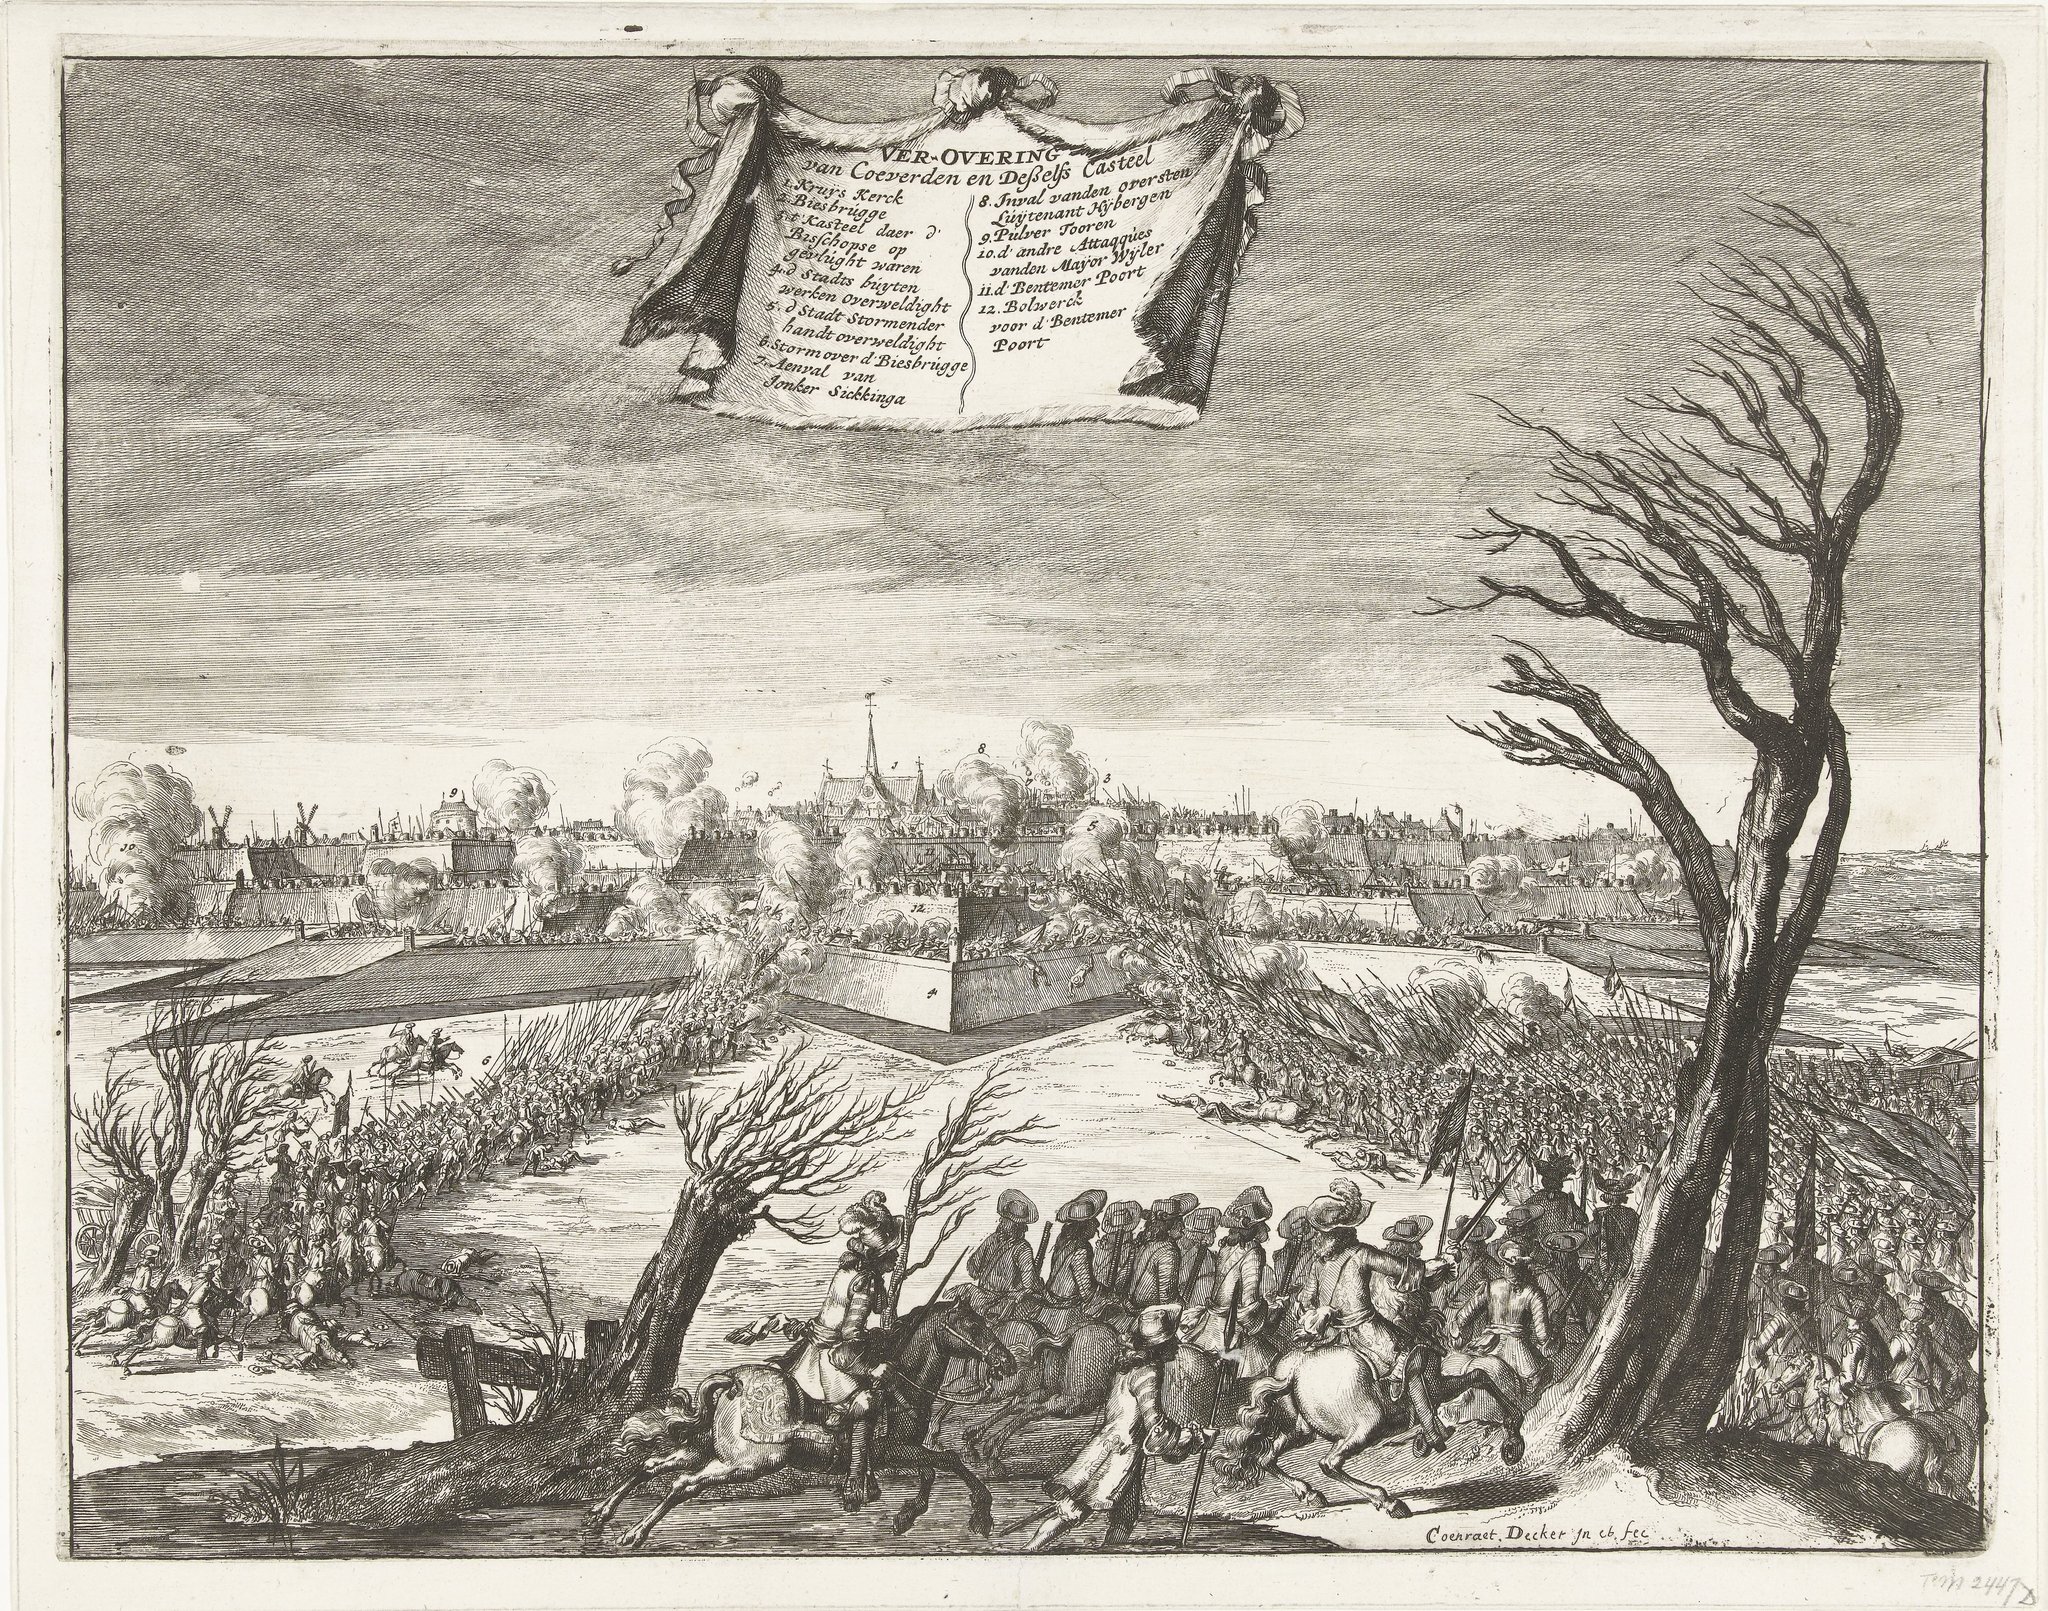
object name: print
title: Bestorming en verovering van Coevorden op 30 december 1672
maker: coenraet decker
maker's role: print maker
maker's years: 1650-1685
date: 1672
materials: paper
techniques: etching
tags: attack ~ siege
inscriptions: collector's mark: Lugt 2228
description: De bestorming en verovering van Coevorden op 30 december 1672 door de troepen onder bevel van generaal Rabenhaupt. Infanterie en cavalerie trekken op in de richting van de vestingswallen om de versterkte stad.In lucht op vaandel verklarende lijst in Nederlandse tekst.